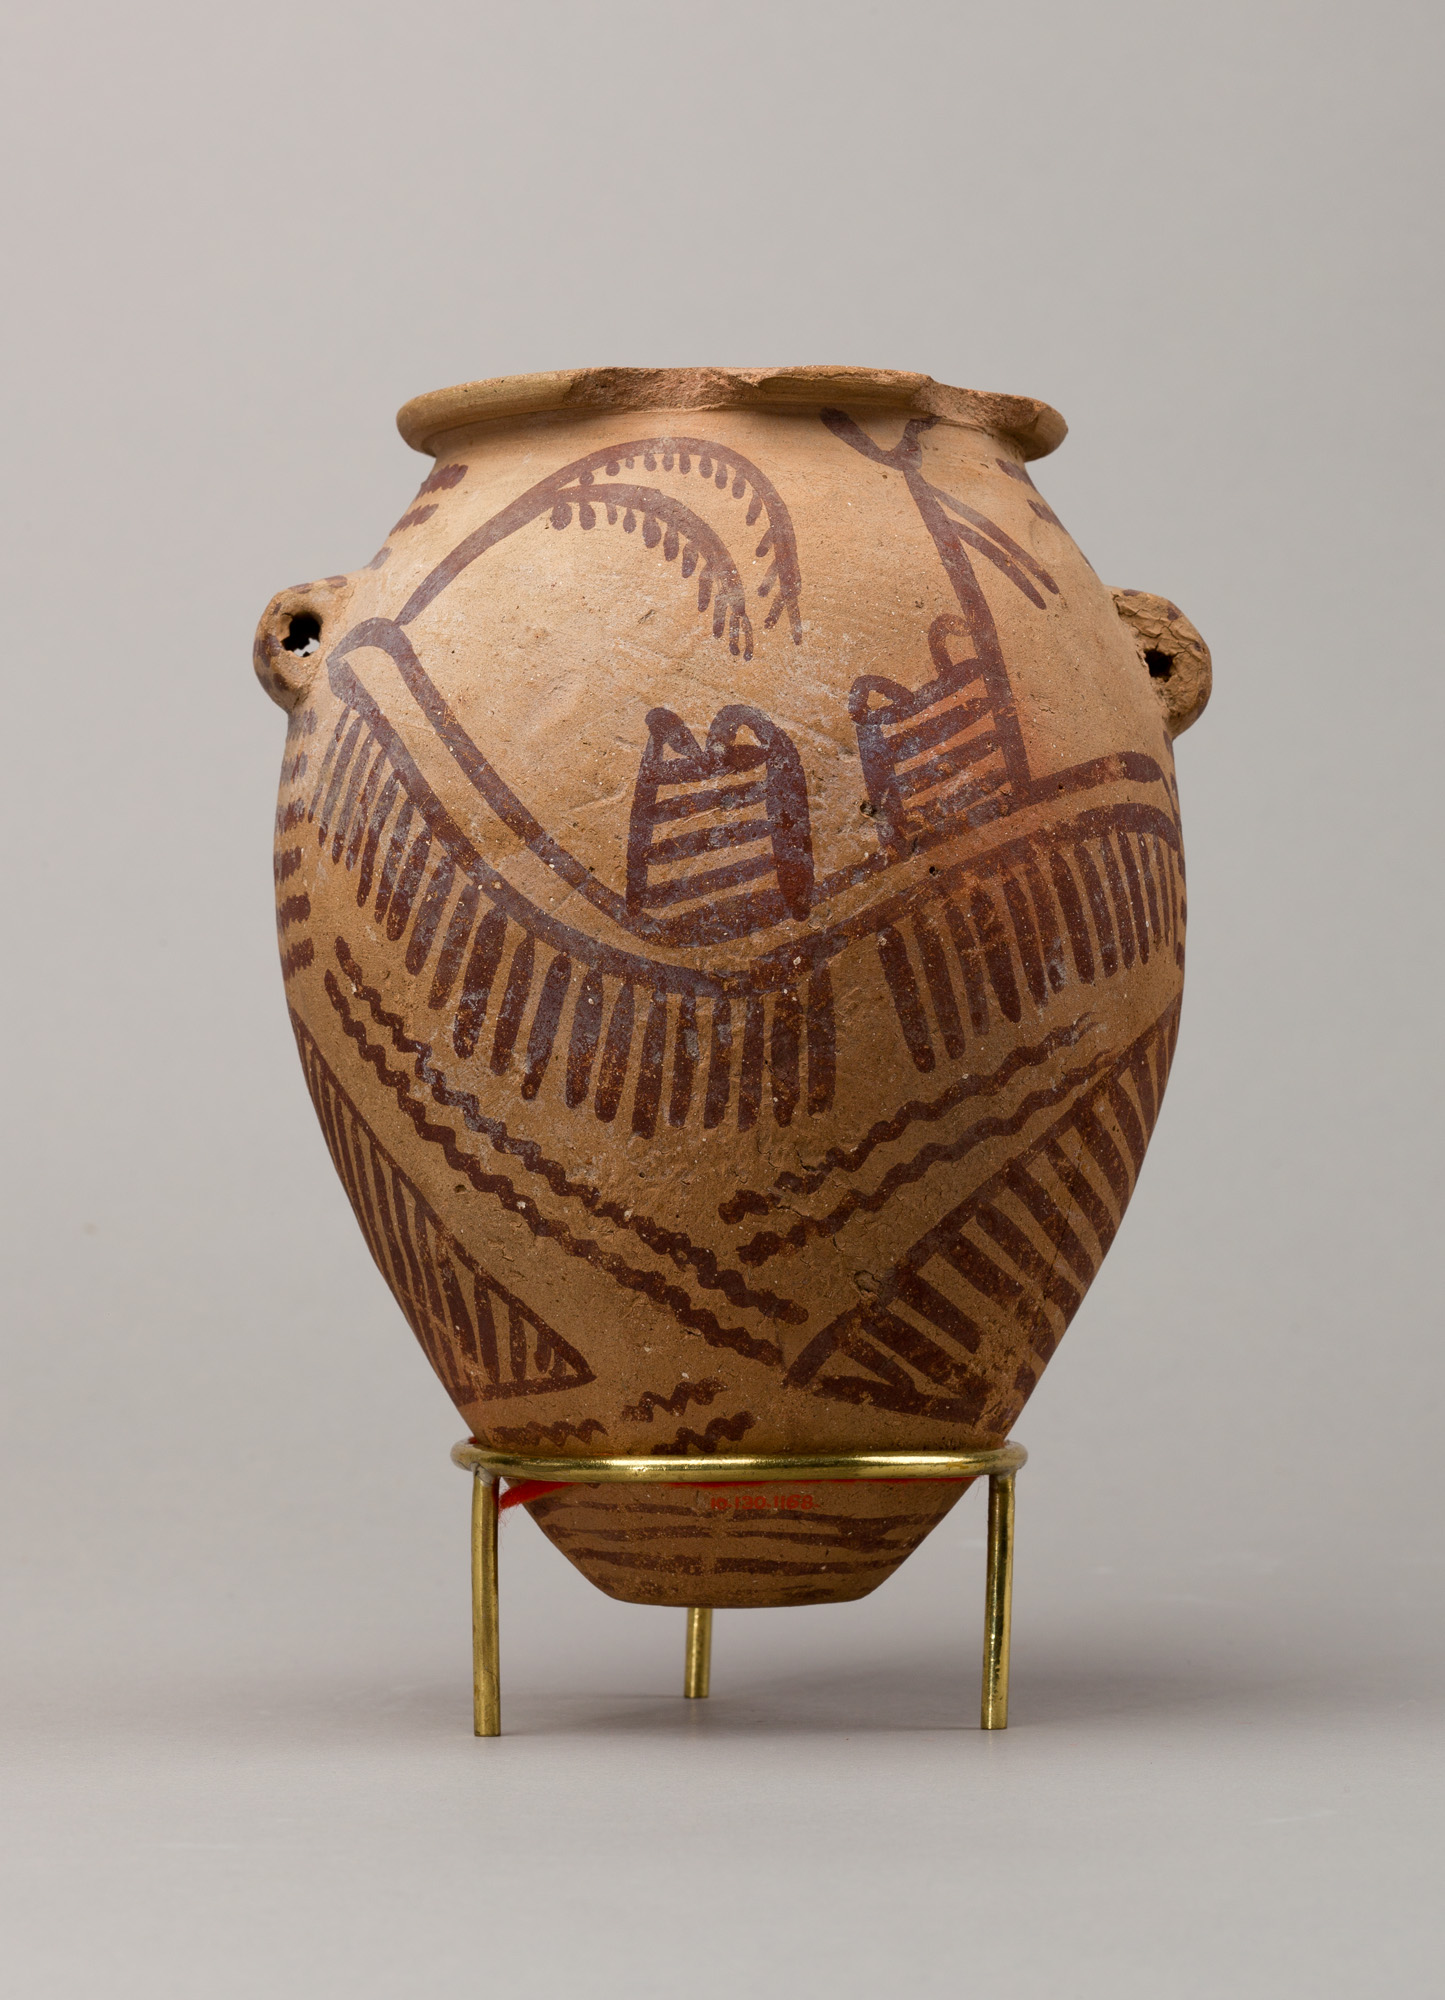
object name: jar, decorated ware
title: Decorated ware jar depicting two boats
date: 3850-2960 BCE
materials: paint, pottery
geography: egypt